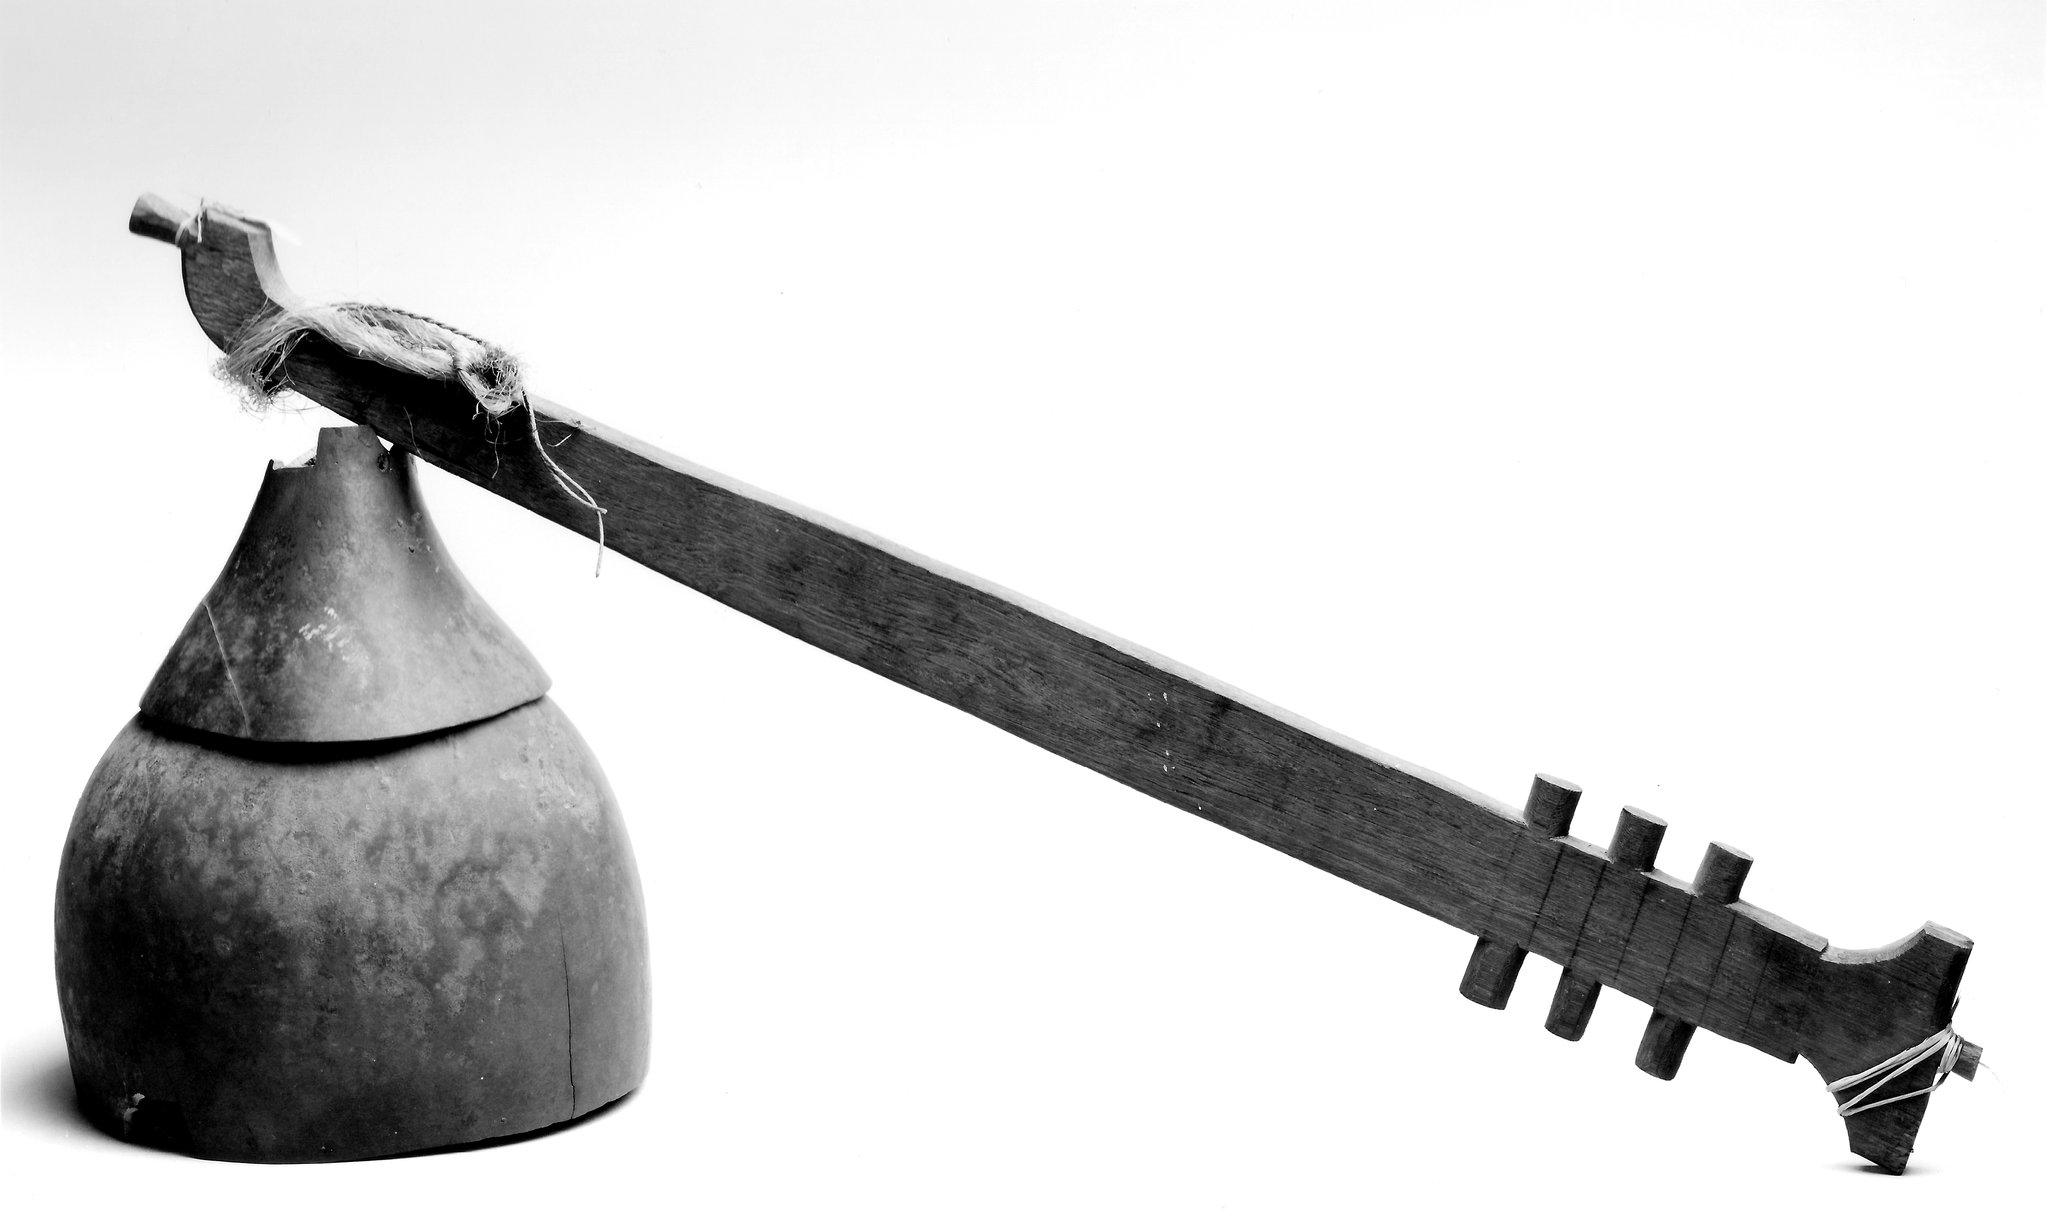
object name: tzetze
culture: kenyan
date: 1867-1900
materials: fiber, wood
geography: kenya